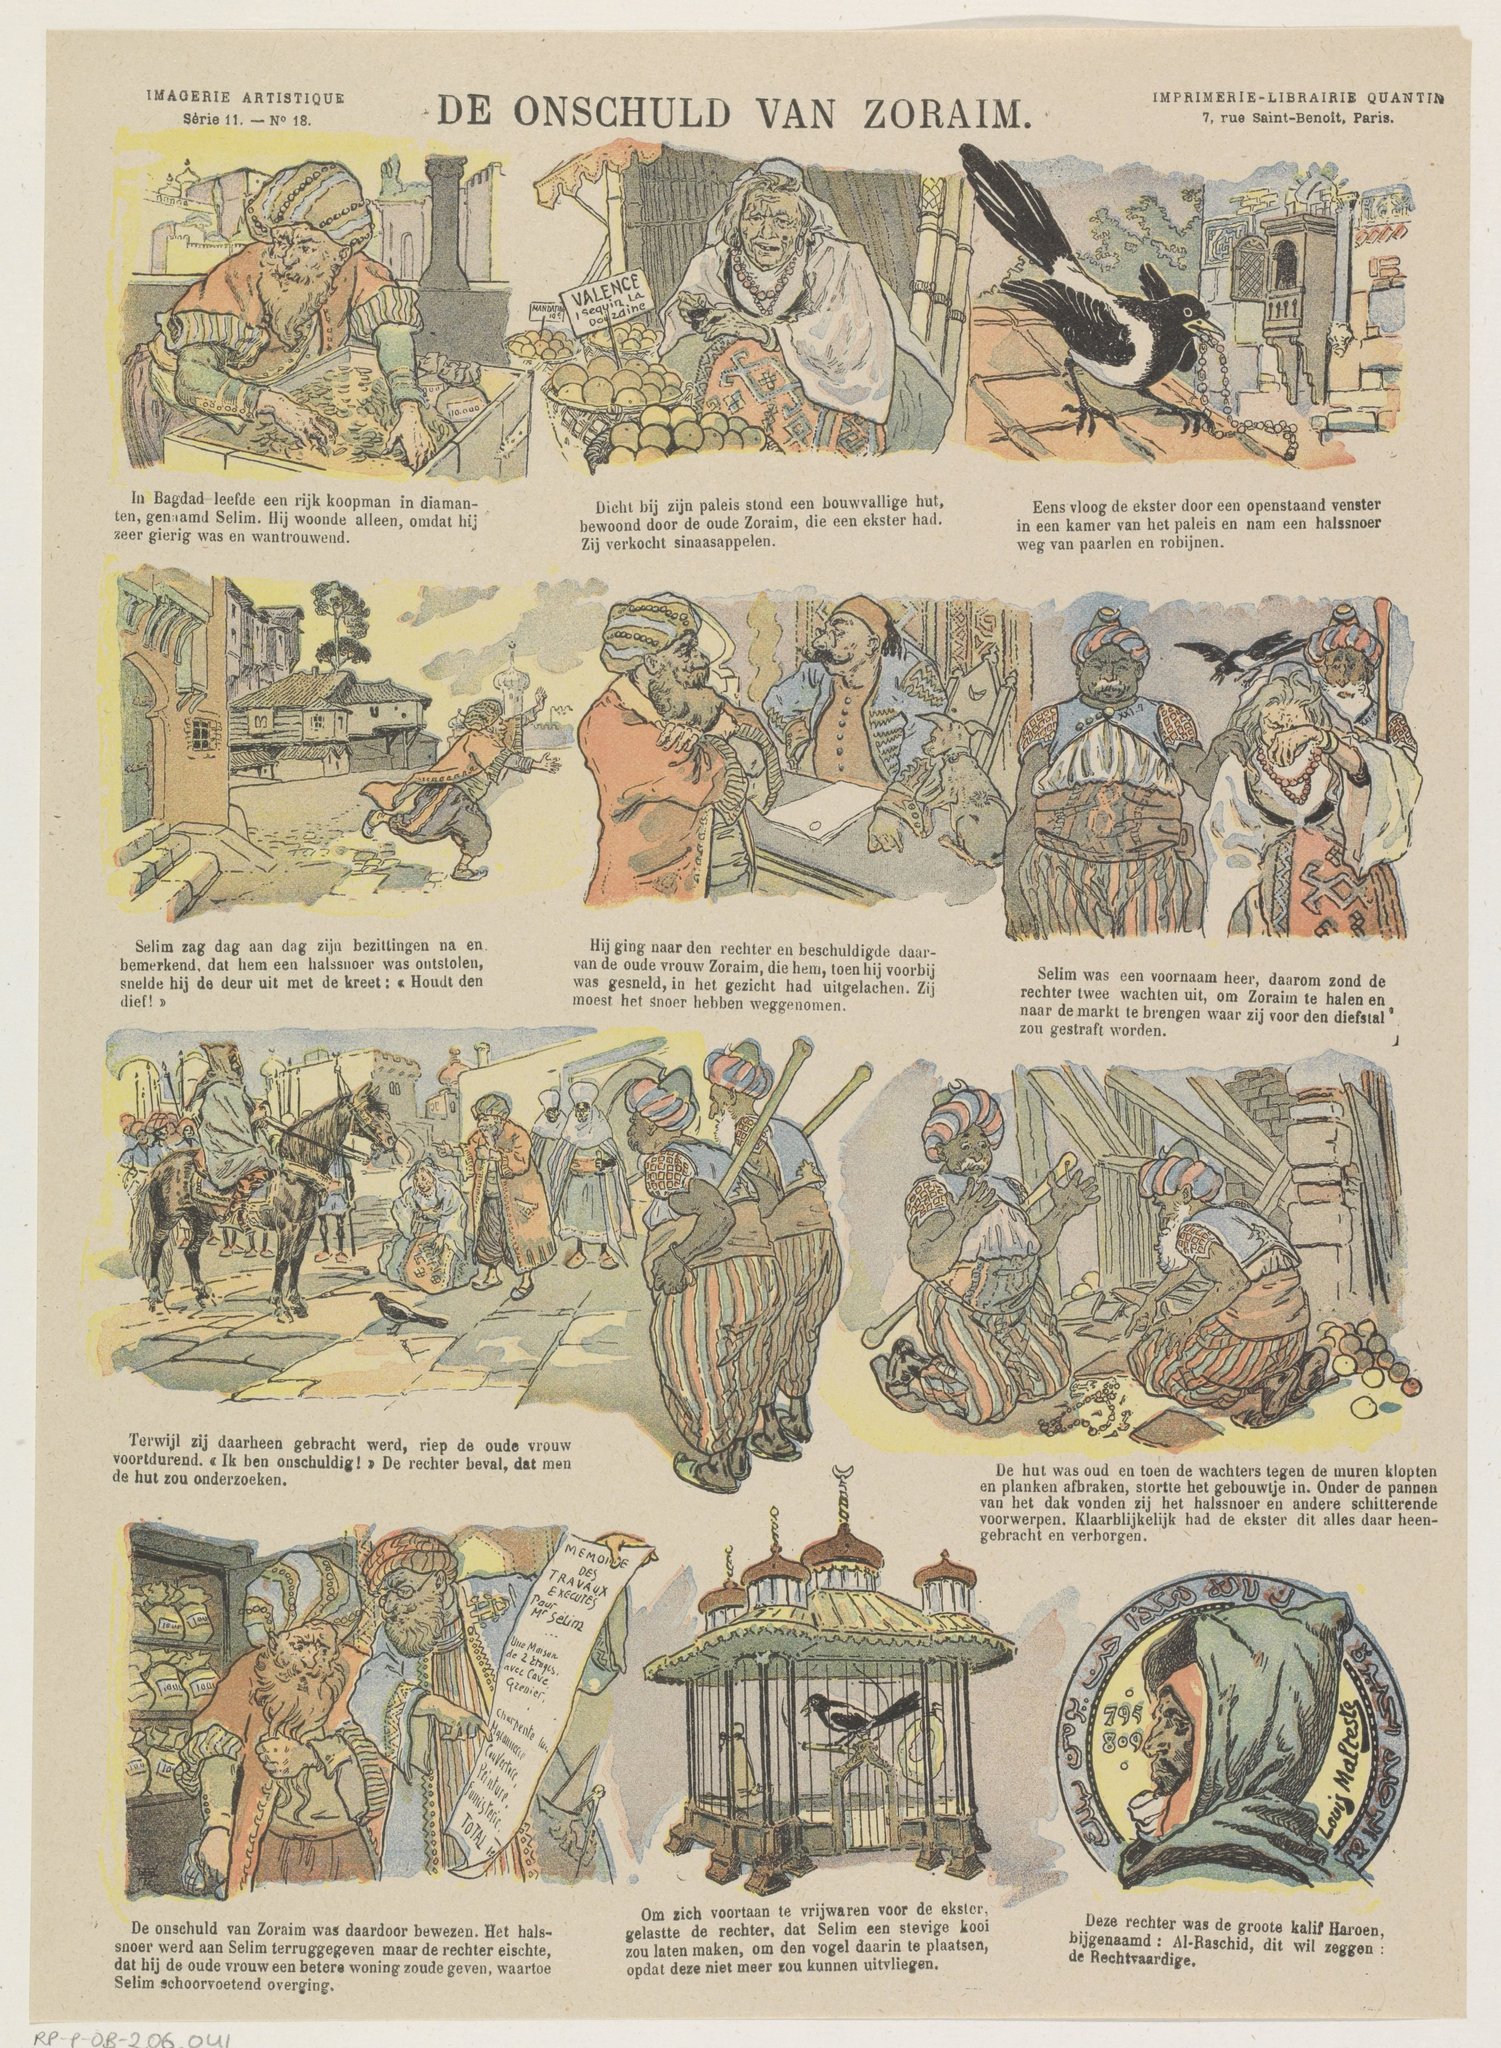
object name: print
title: Imagerie Artistique / Série 11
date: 1876-1890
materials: paper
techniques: lithograph, letterpress printing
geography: paris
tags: theft, tales and fairy tales, song-birds: magpie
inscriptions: collector's mark: Lugt 2760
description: Blad met 11 voorstellingen van de ekster van Zoraim die de halsketting van Selim steelt. Onder elke afbeelding een onderschrift. Genummerd linksboven: Série 11. - No. 18.